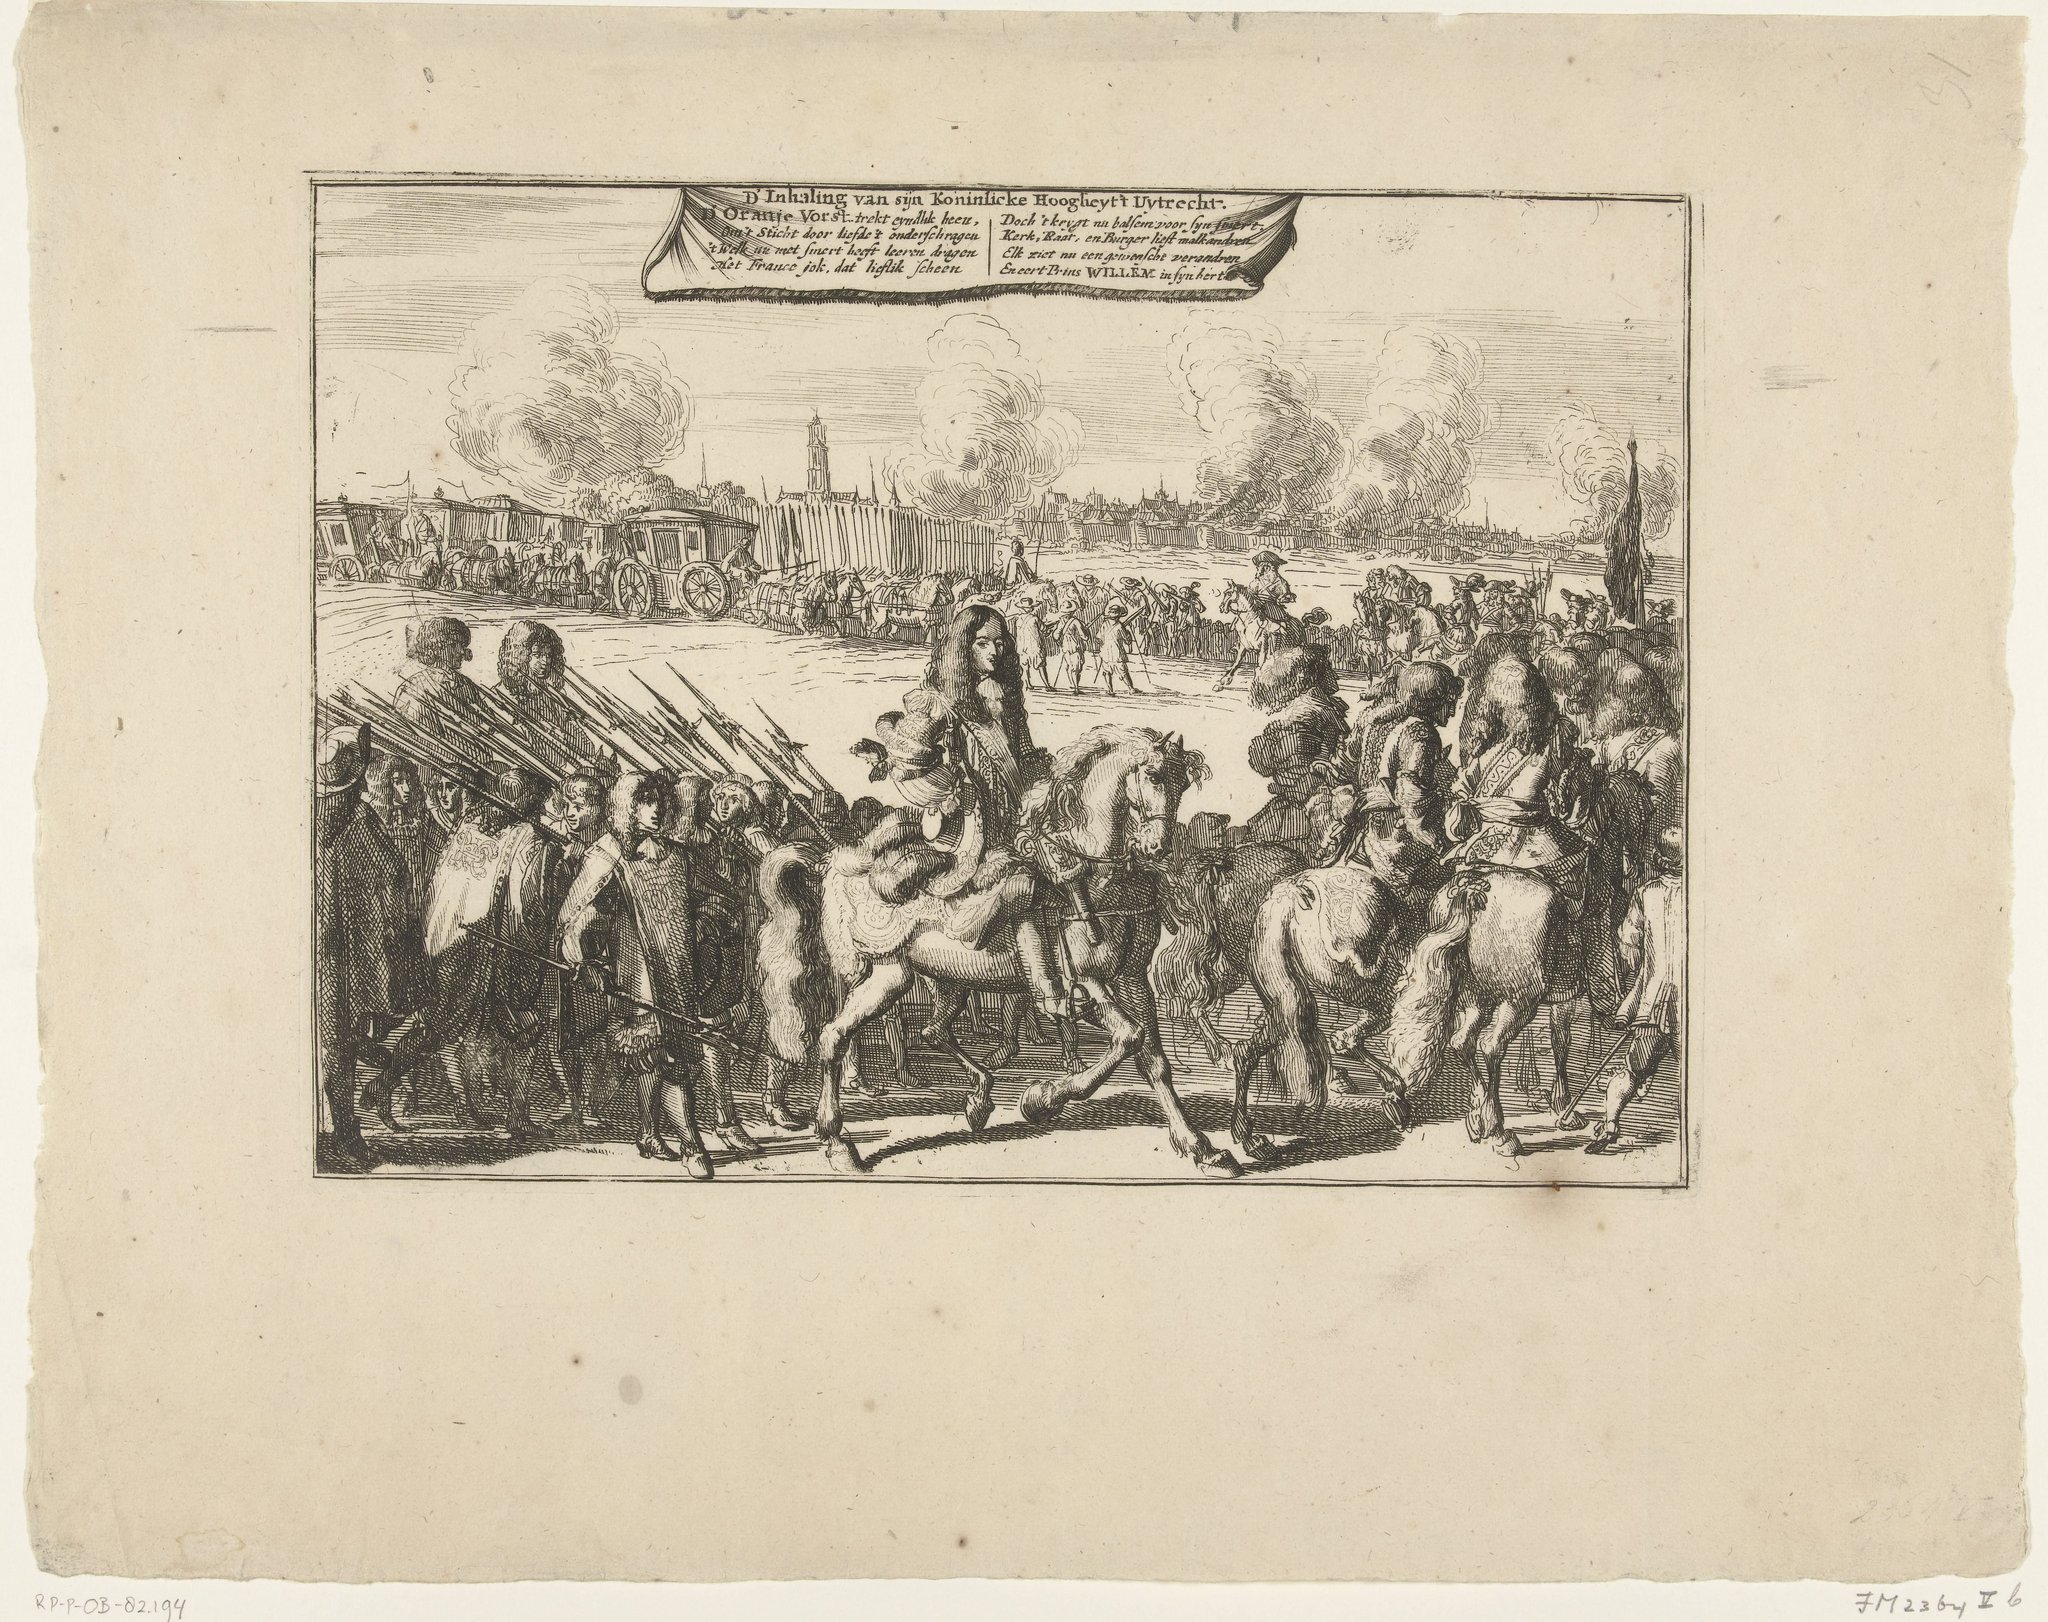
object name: history print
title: D'Inhaling van sijn Koninlicke Hoogheyt 't Uytrecht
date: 1674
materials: paper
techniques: etching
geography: amsterdam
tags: the hague, william iii (prince of orange and king of england, scotland, and ireland), triumphal entry and public reception, pageant, 'entrée solennelle', 'joyeuse entrée', utrecht, rampjaar (disaster year)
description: De aankomst van prins Willem III te Utrecht in april 1674. De prins centraal te paard te midden van ruiters en voetsoldaten. Op de achtergrond de stad Utrecht. Bovenaan een doek met de titel en twee vierregelige verzen in het Nederlands. Vijfde (ongenummerde) prent in een reeks van vijf prenten over de gebeurtenissen voorgevallen in Utrecht over de periode 1672-74.